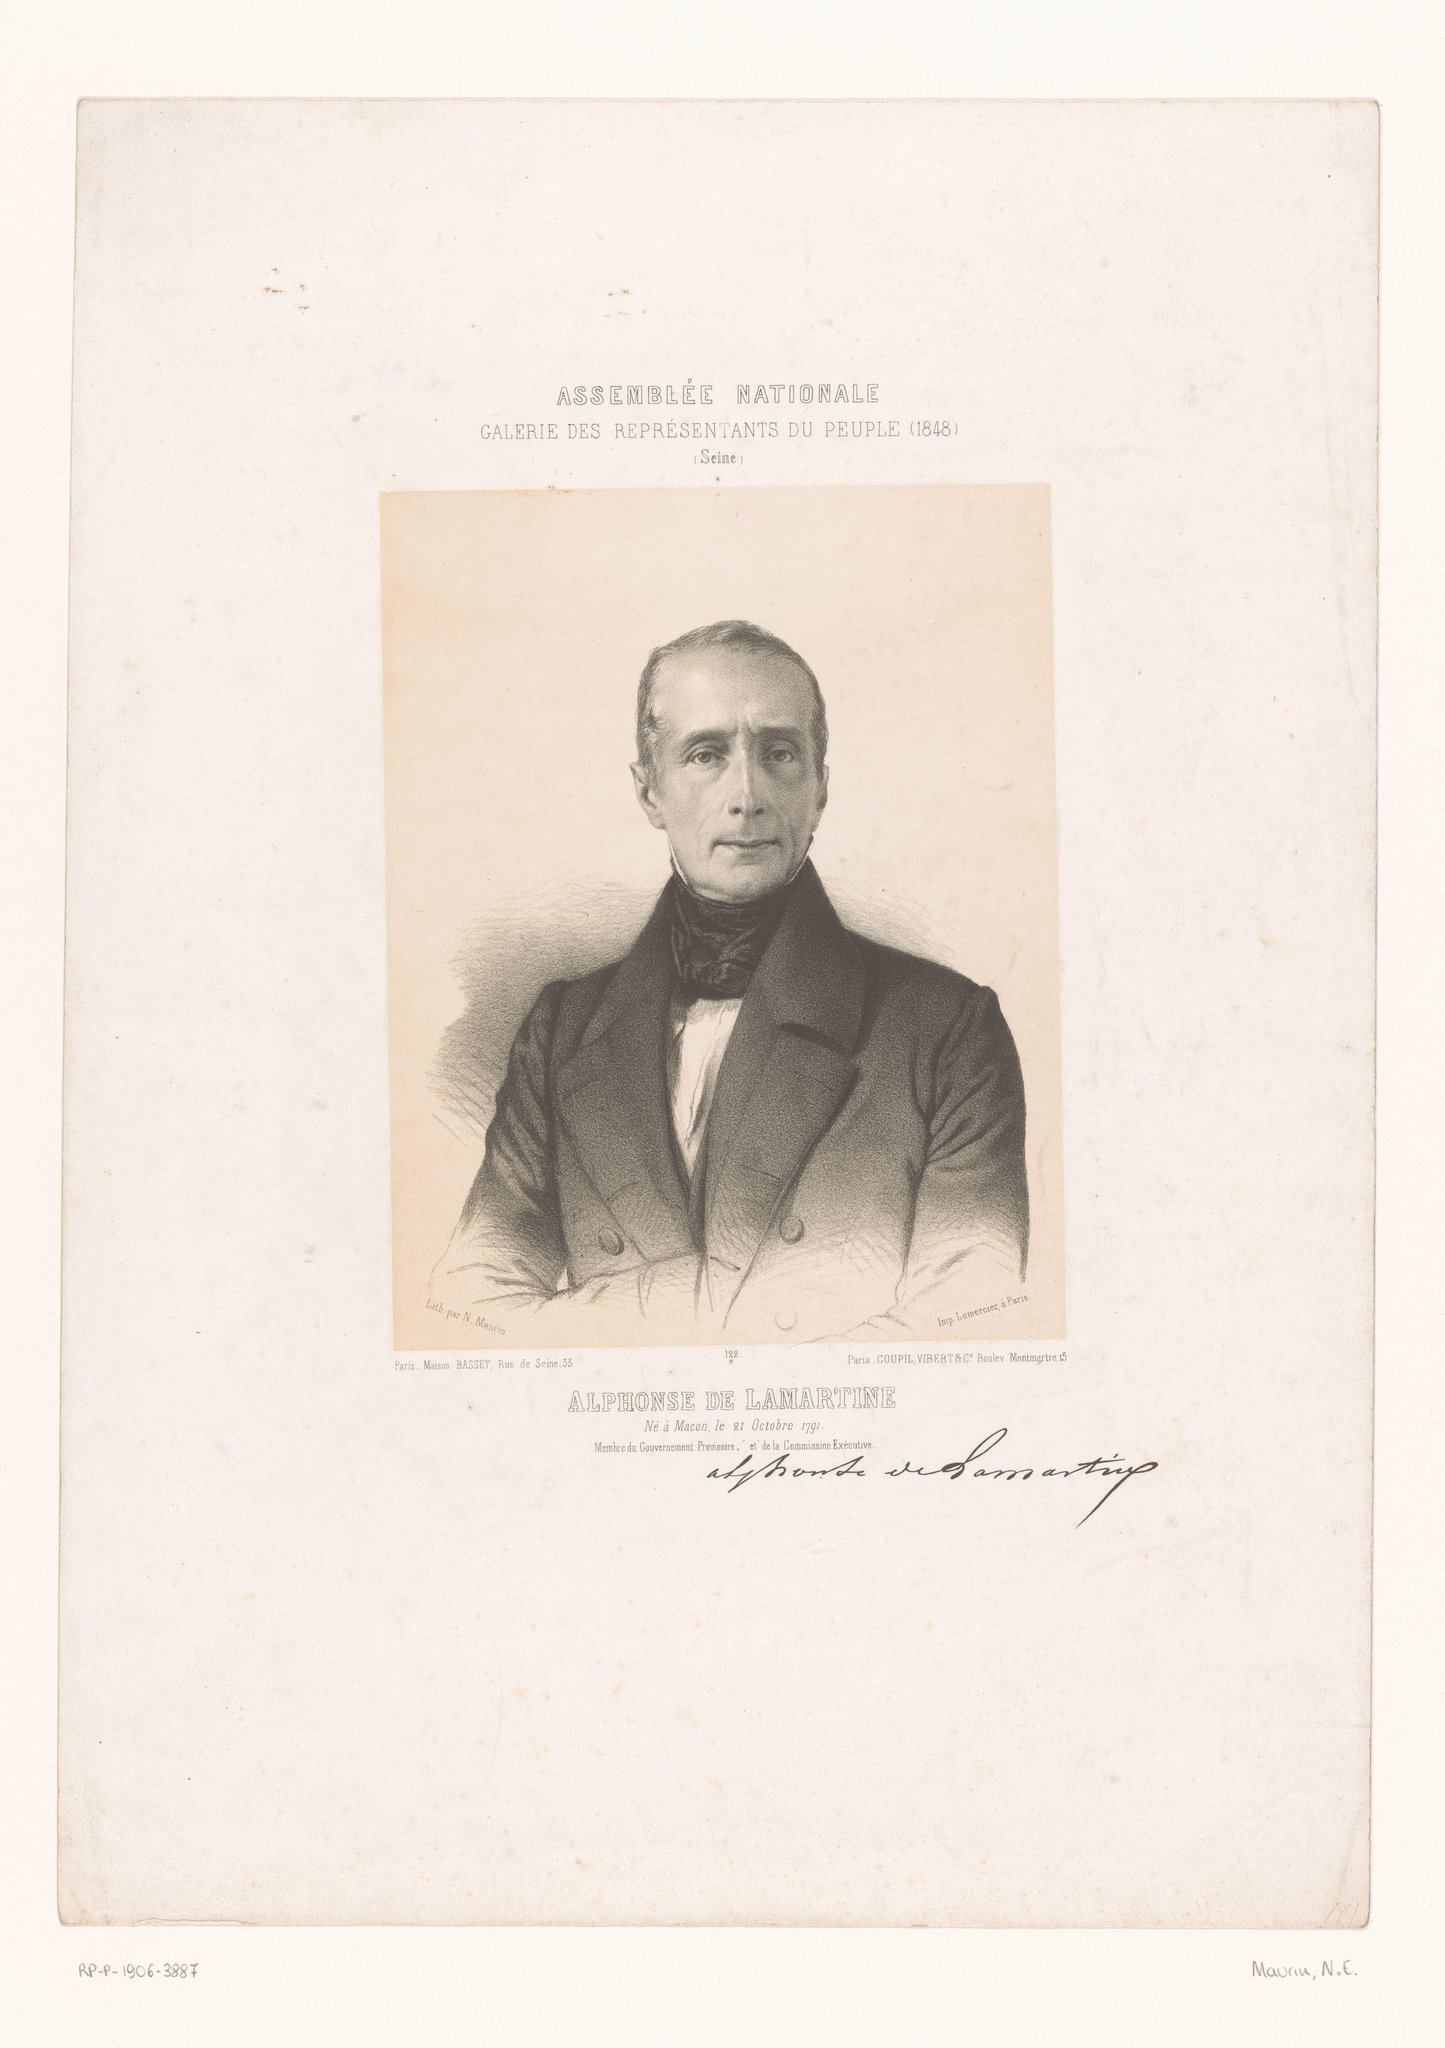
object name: print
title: Portret van Alphonse de Lamartine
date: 1848-1849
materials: paper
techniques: tone lithography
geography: paris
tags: paris, historical persons, politician, e.g. party leader, writer, poet, author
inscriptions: collector's mark: Lugt 2228